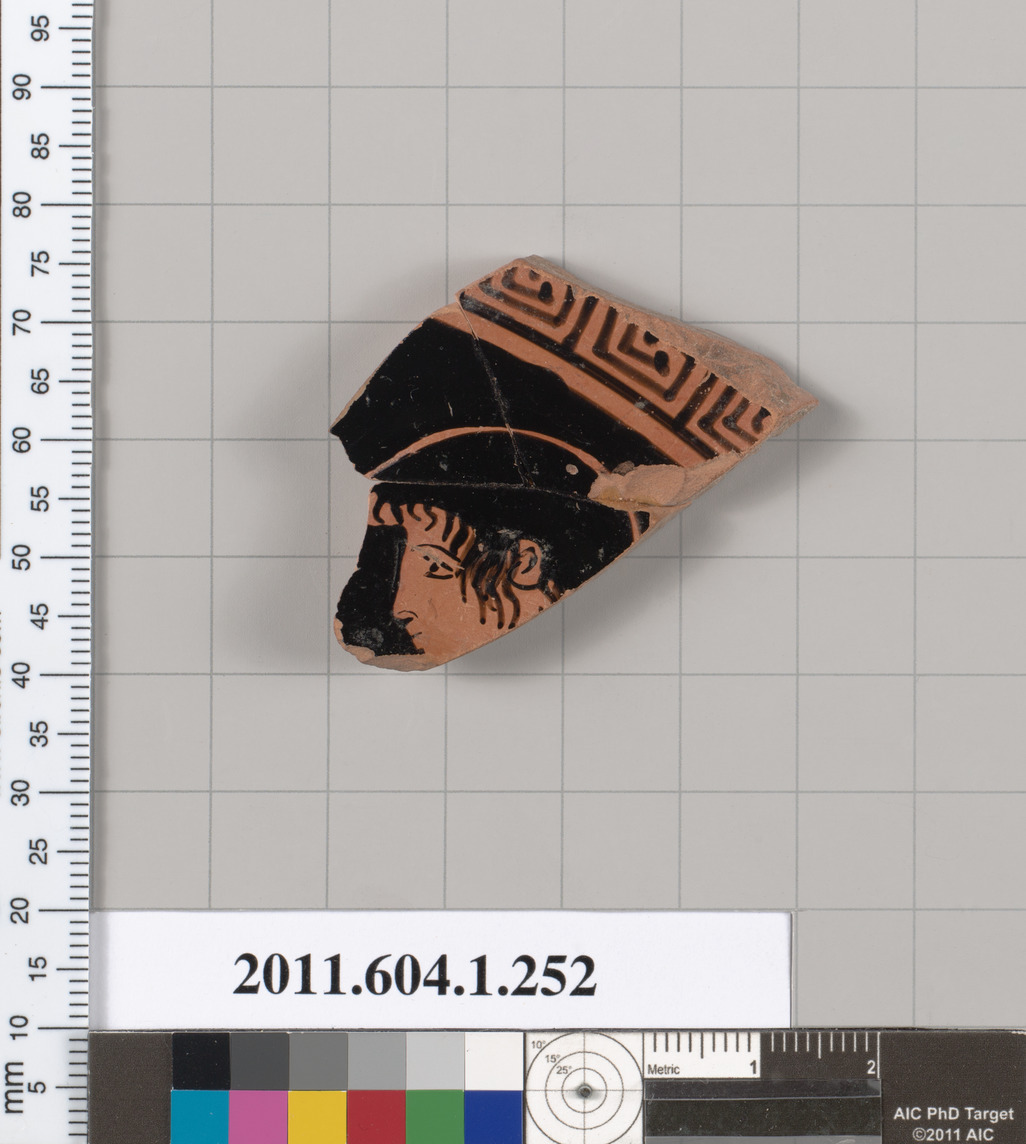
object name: kylix fragment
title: Terracotta fragment of a kylix (drinking cup)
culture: greek, attic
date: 475-451 BCE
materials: terracotta